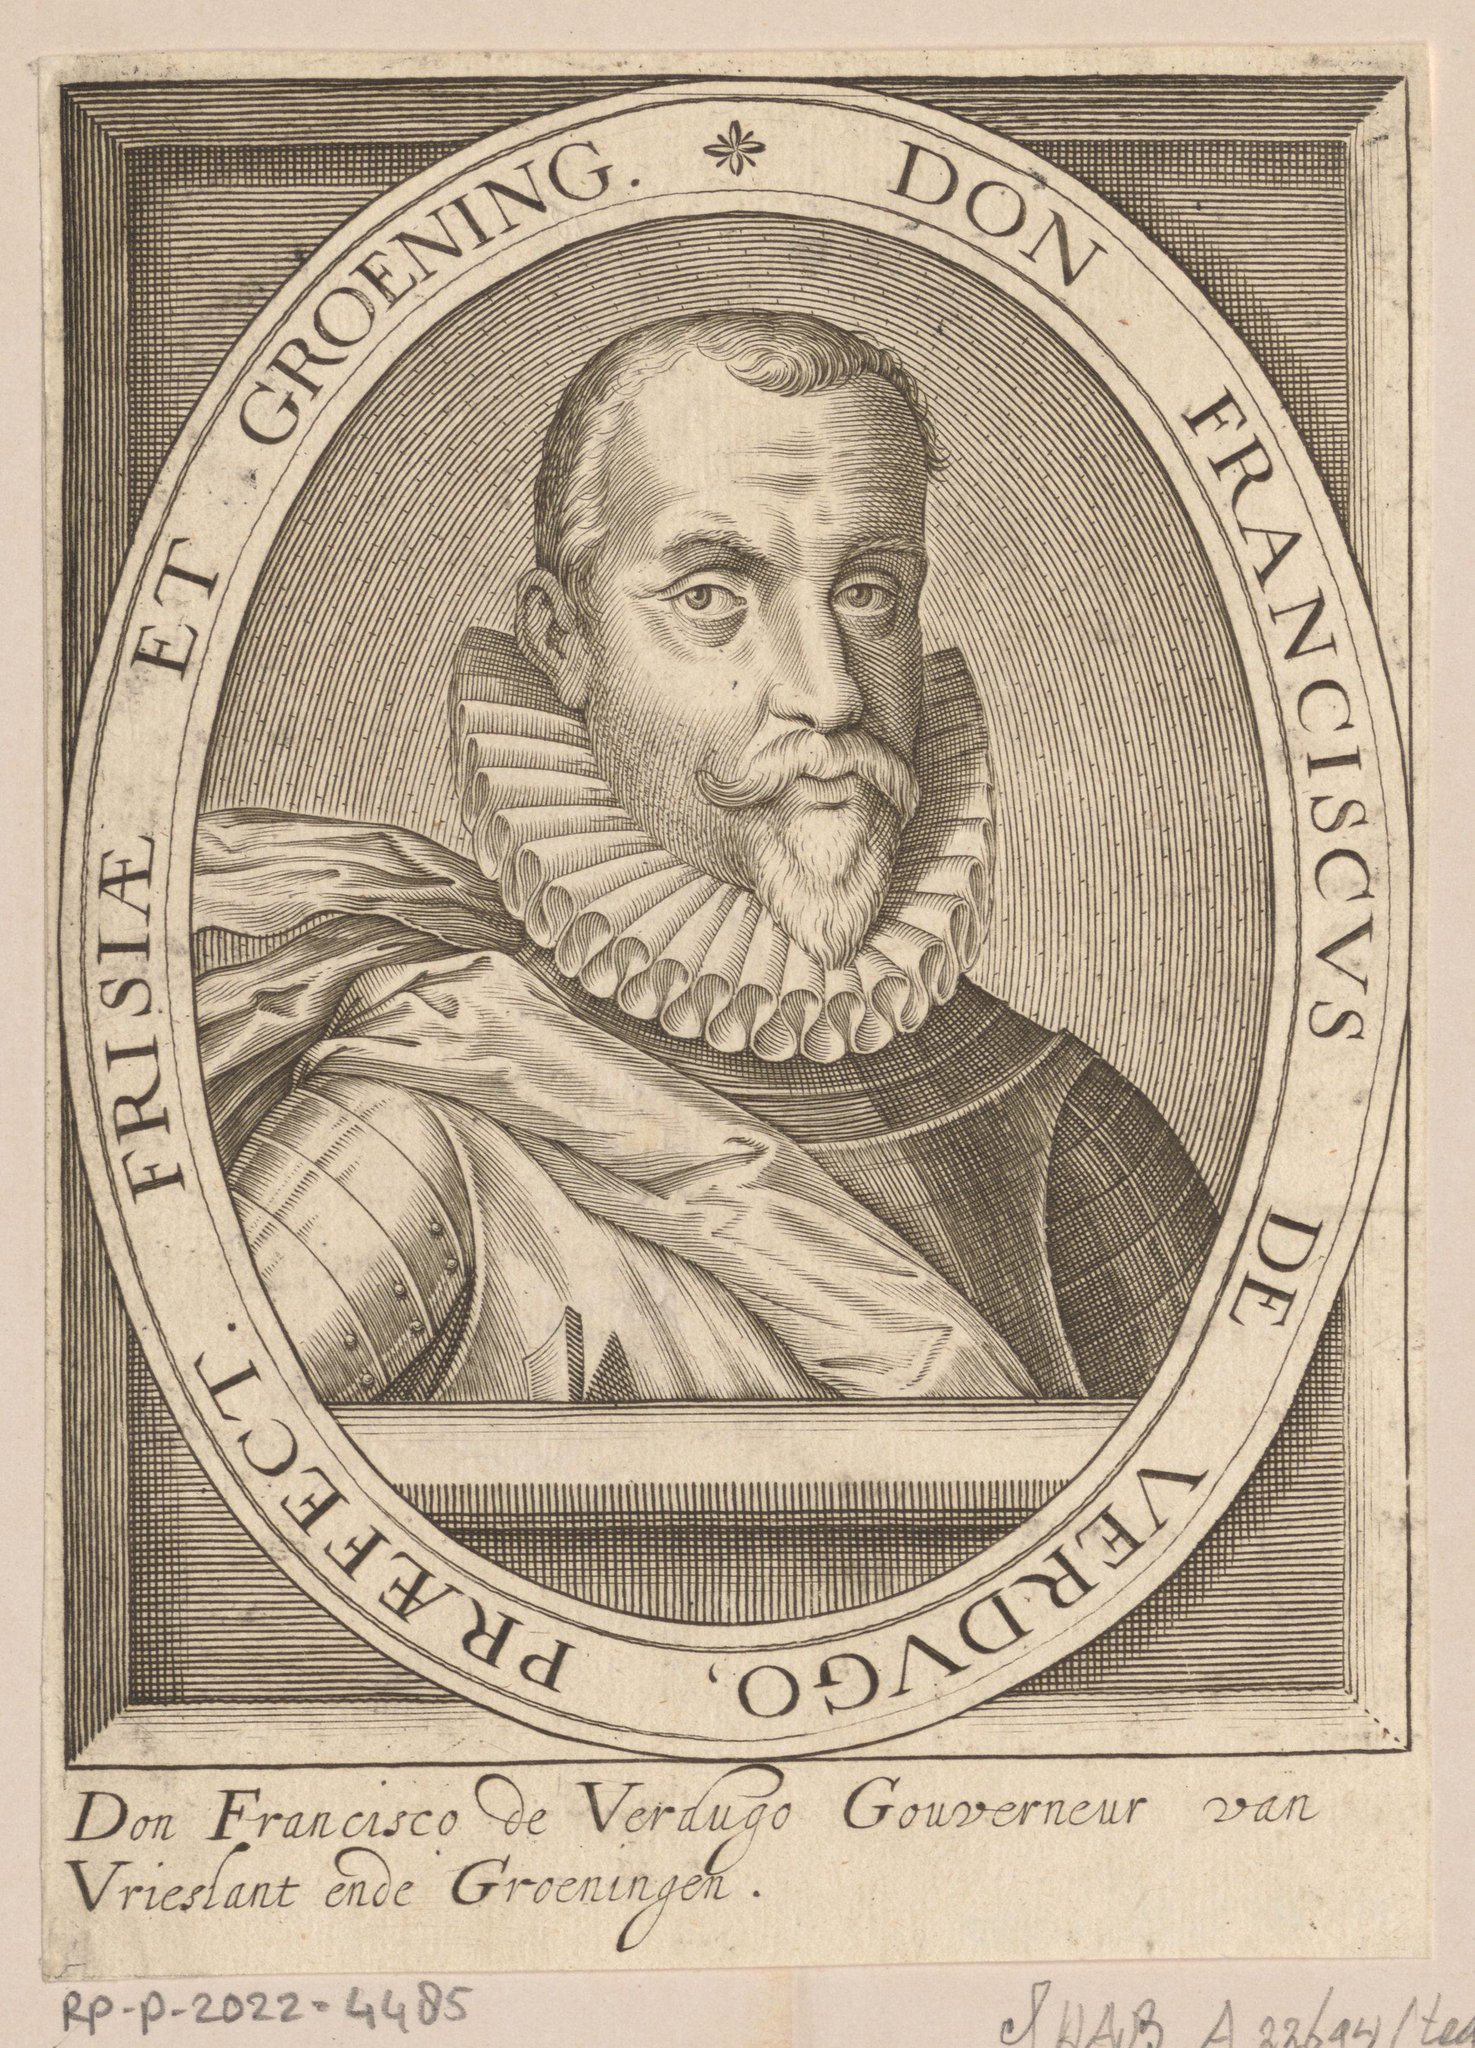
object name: print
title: Portret van Francisco Verdugo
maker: Anonymous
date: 1663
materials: paper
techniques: engraving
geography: low countries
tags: historical persons, stadtholder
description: Prent waarschijnlijk uit: Meteren, Emanuel van. Historien der Nederlanden, en haar naburen oorlogen tot het jaar 1612. Amsterdam: Jan Jacobsz Schipper, 1663.